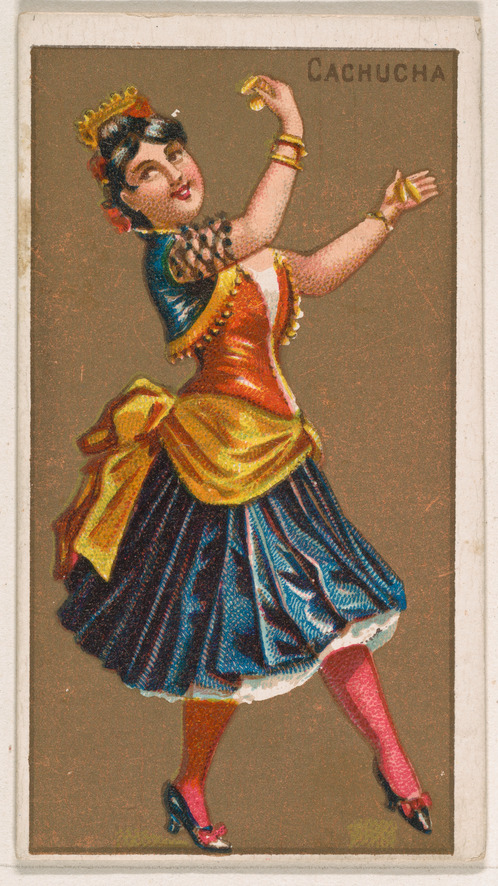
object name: print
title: Cachucha, from National Dances (N225, Type 1) issued by Kinney Bros.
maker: kinney brothers tobacco company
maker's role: publisher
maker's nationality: american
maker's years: 1869-2011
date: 1889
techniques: color lithograph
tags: women,dancing,dancers